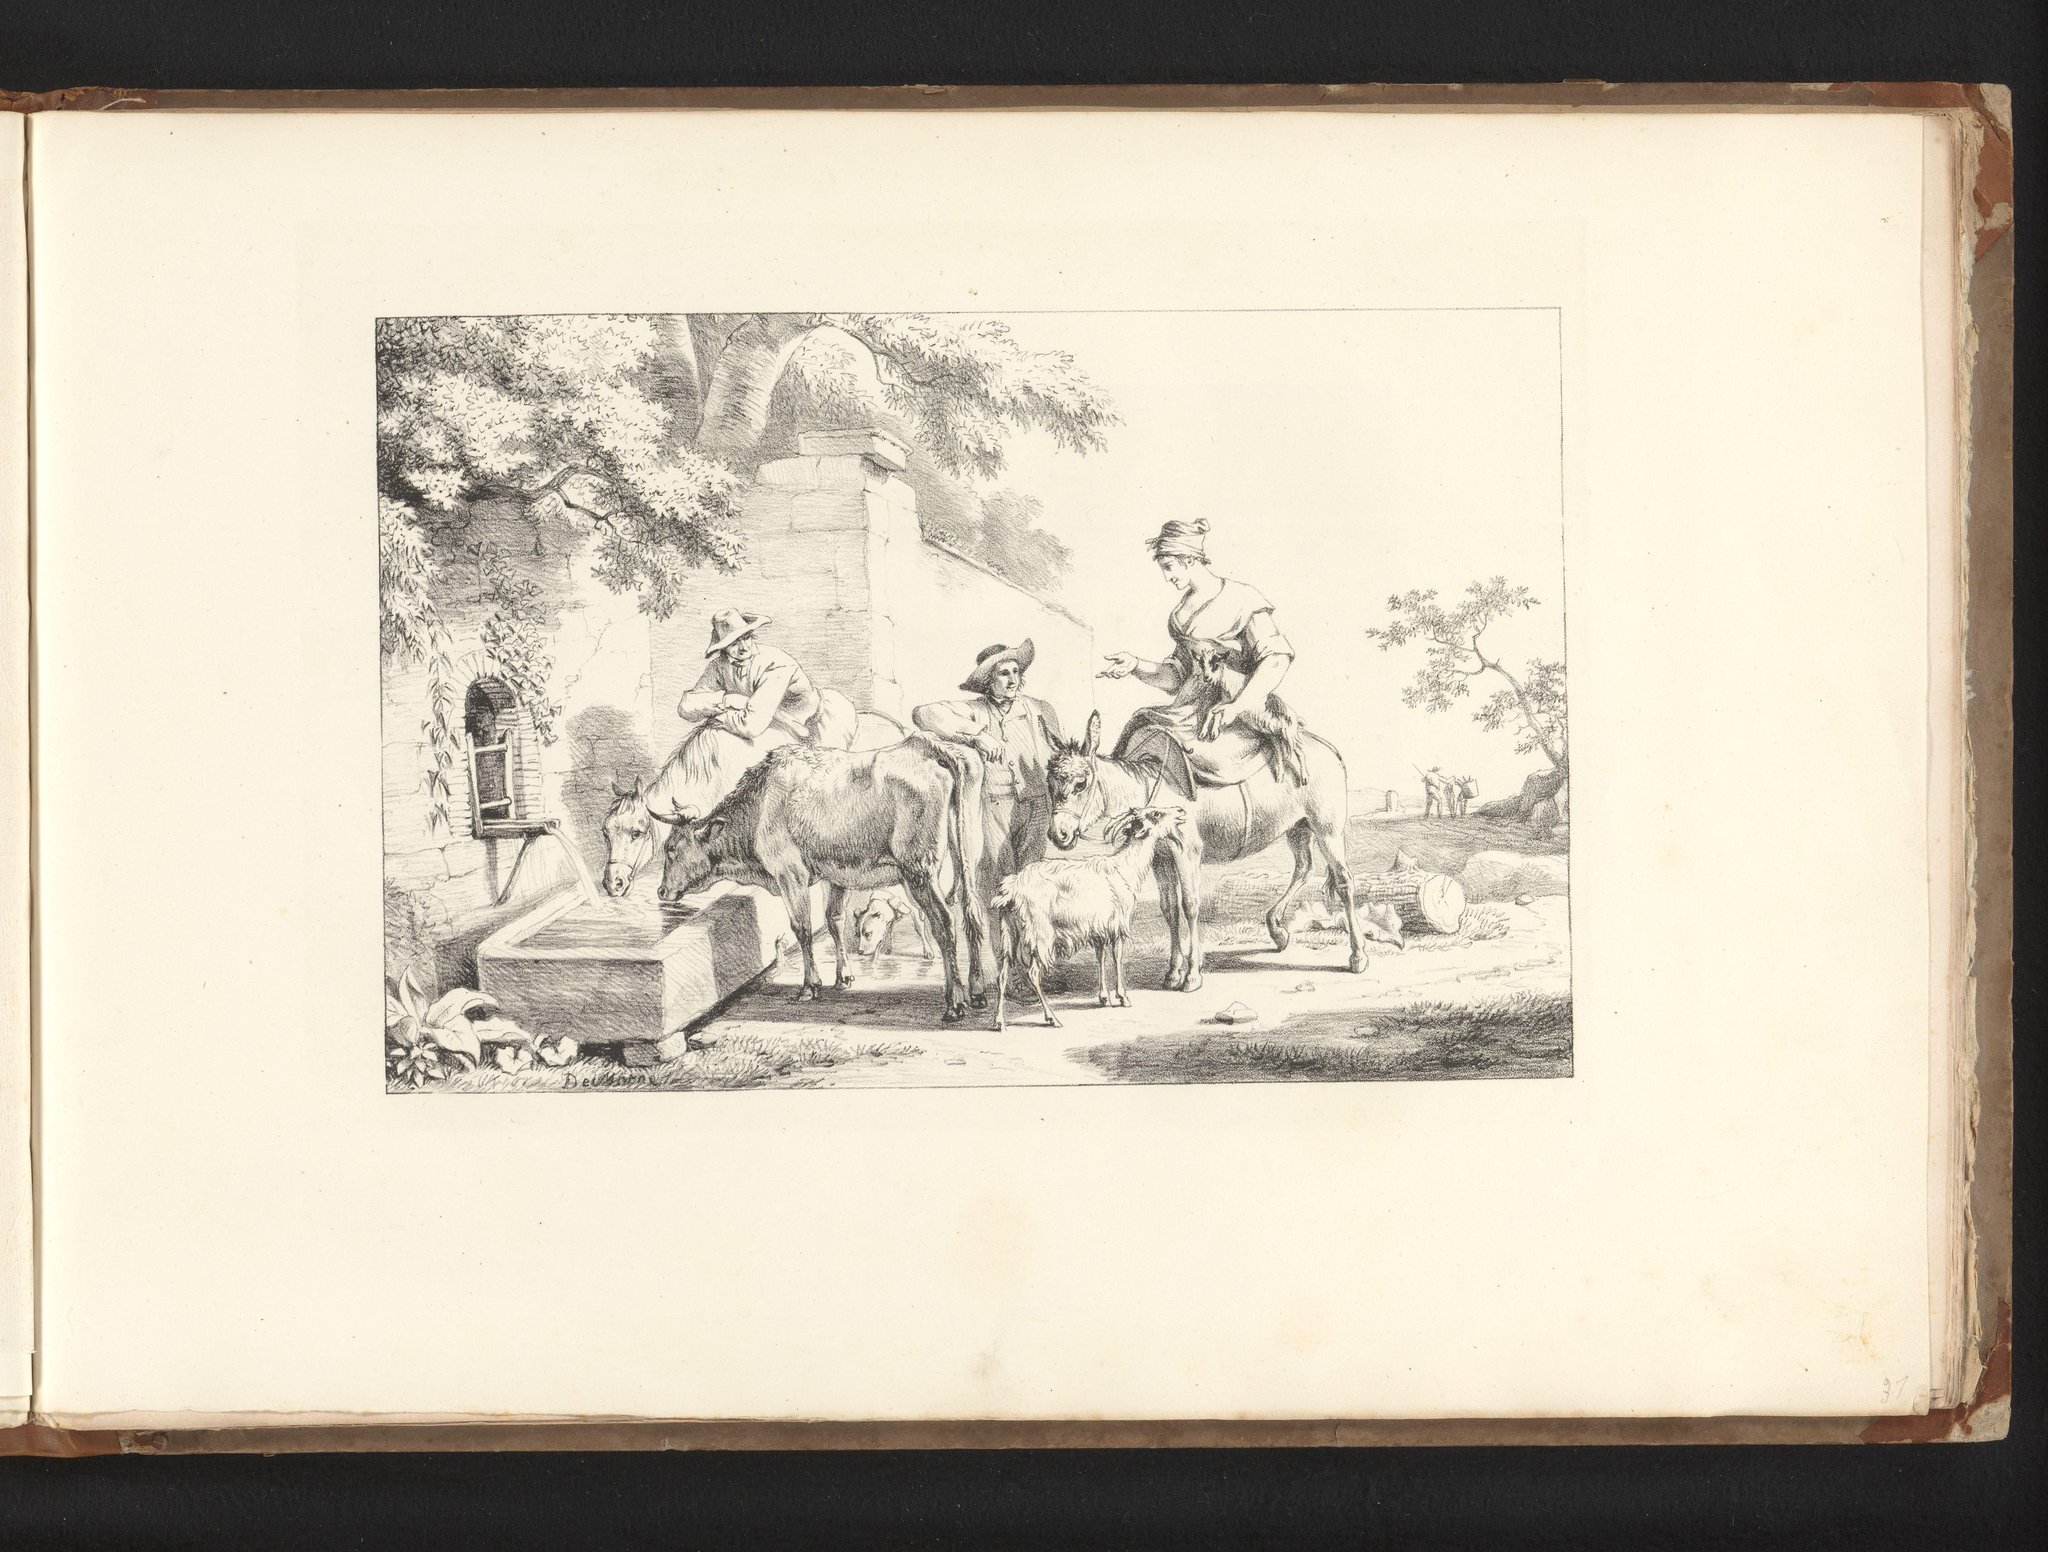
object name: print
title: Herders bij een bron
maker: Anonymous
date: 1818-1819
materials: paper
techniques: lithograph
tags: herd, flock